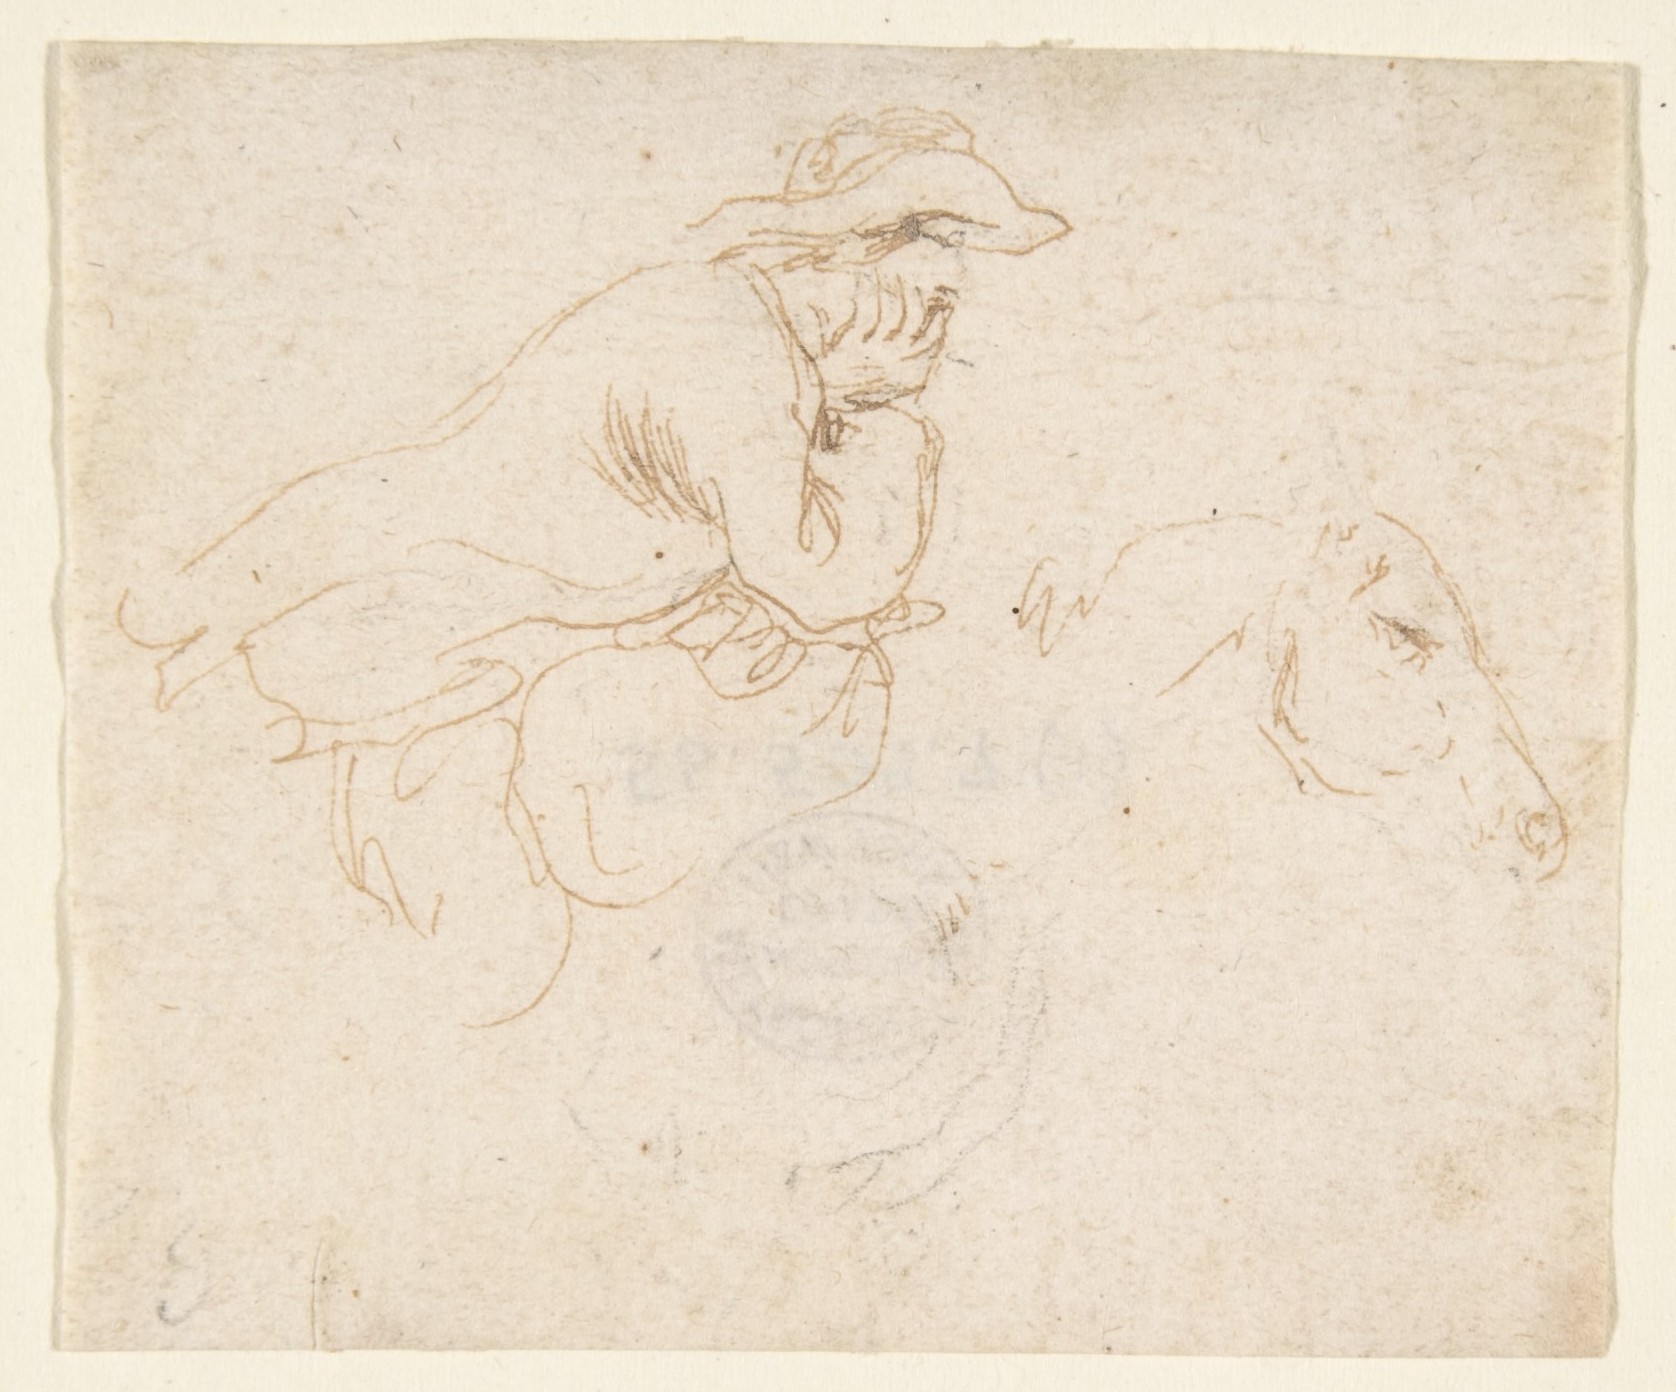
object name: drawing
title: Man on Horseback seen in Profile View Facing Right.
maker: stefano della bella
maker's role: artist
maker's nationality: italian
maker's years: 1610-1664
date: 1610-1664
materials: ink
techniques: pen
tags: men,horses